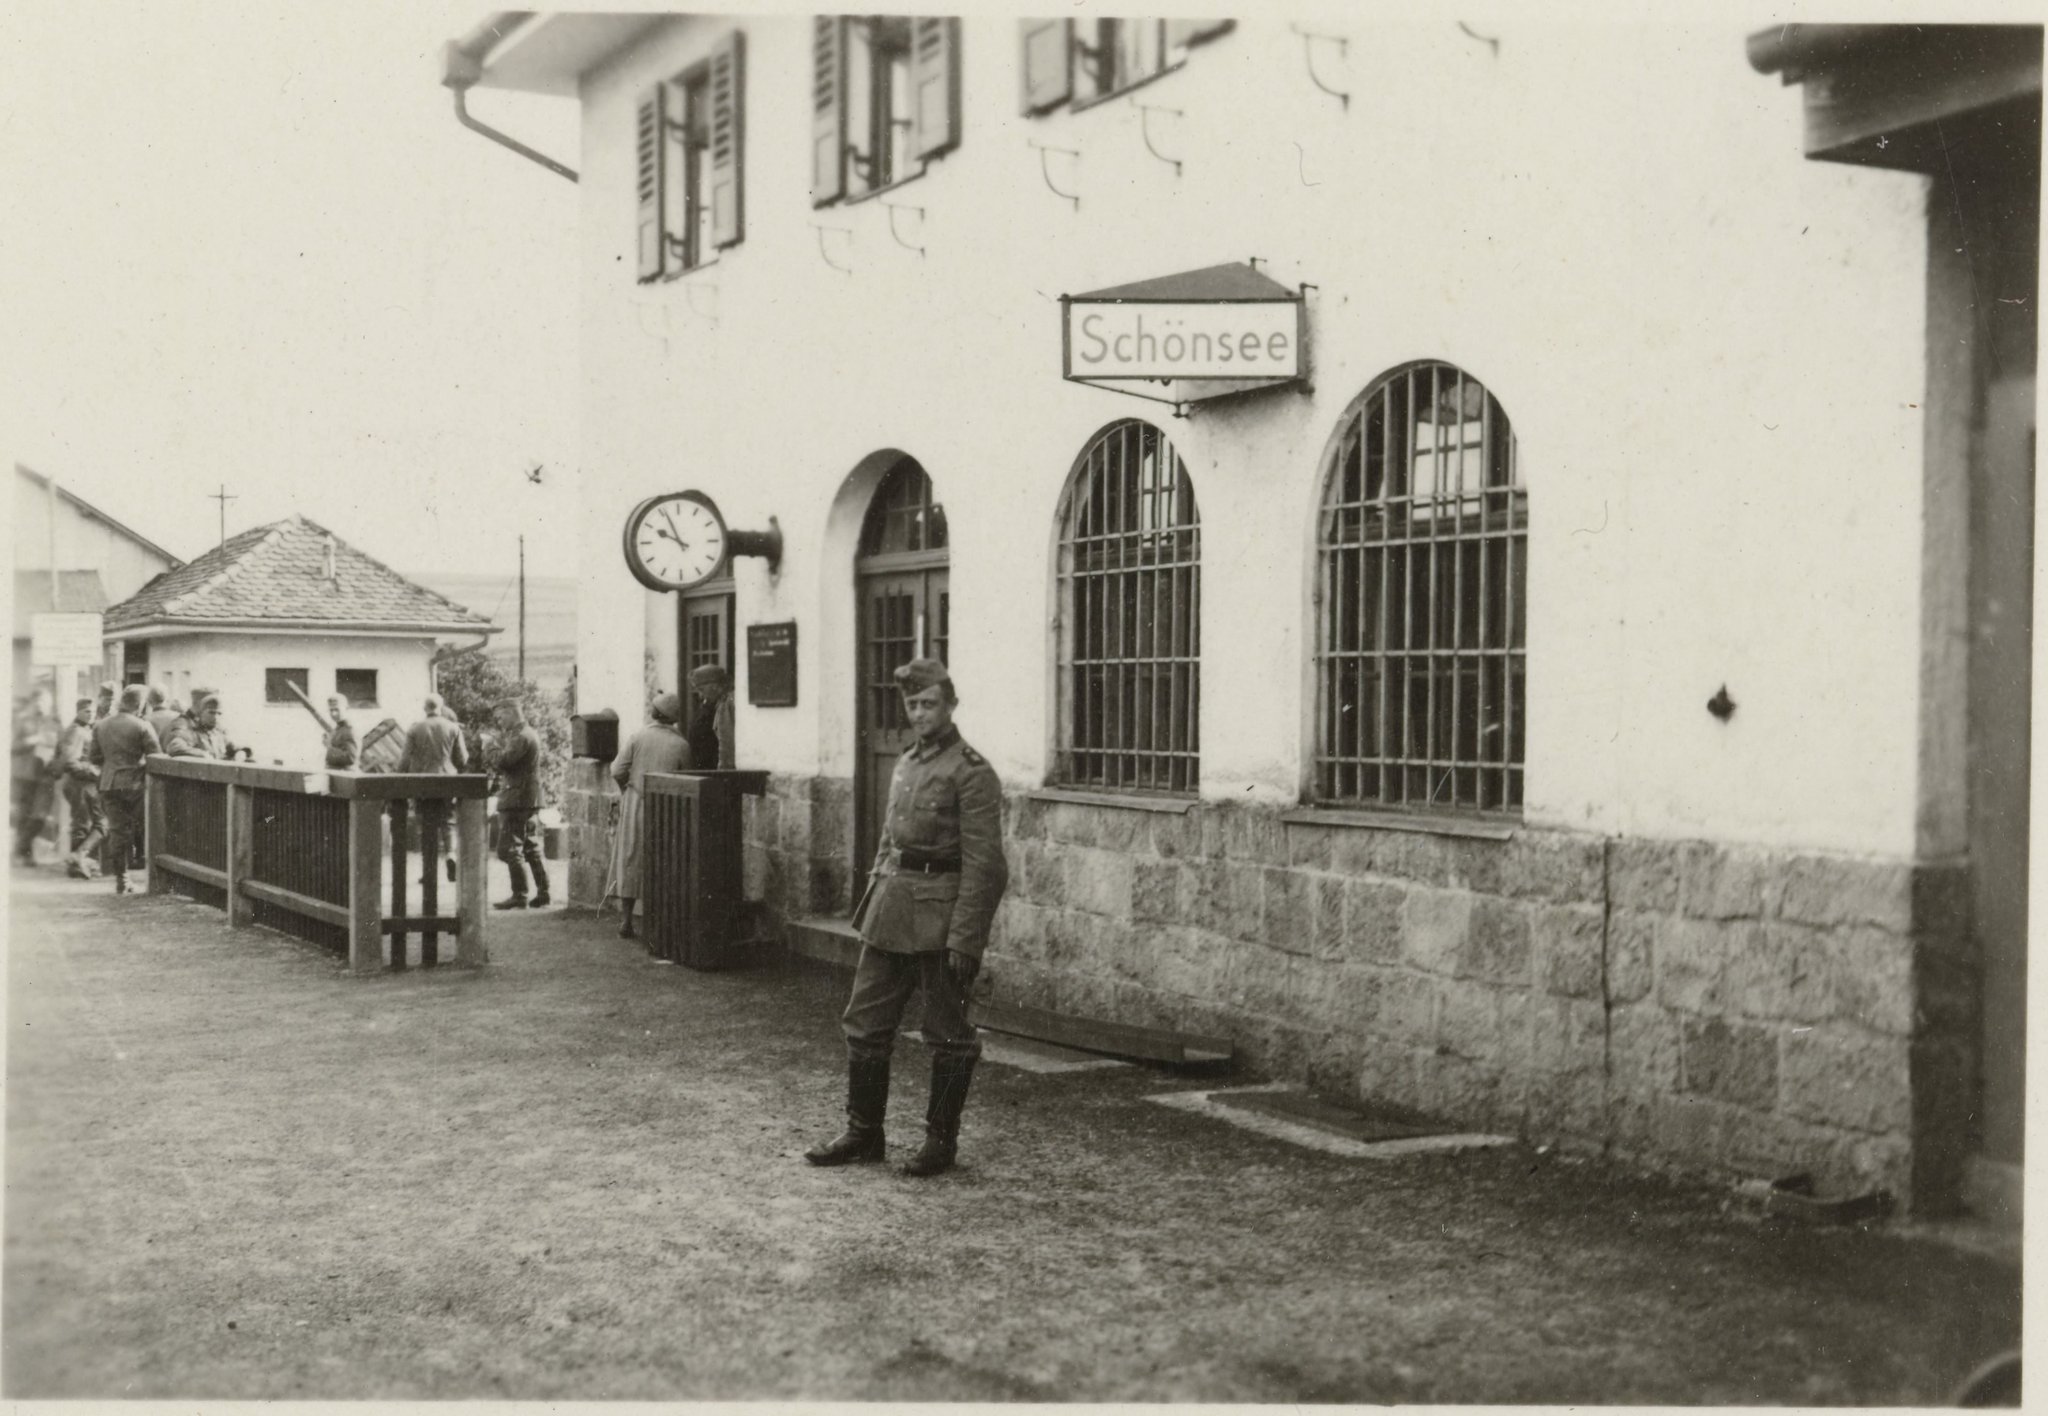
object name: photograph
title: Schönsee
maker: Anonymous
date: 1940-1945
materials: photographic support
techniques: gelatin silver print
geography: czechoslovakia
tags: netherlands, germany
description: Een soldaat staat voor een gebouw met een klok en een bord: Schönsee. Foto behorend bij album 'Kriegserinnerungen'.